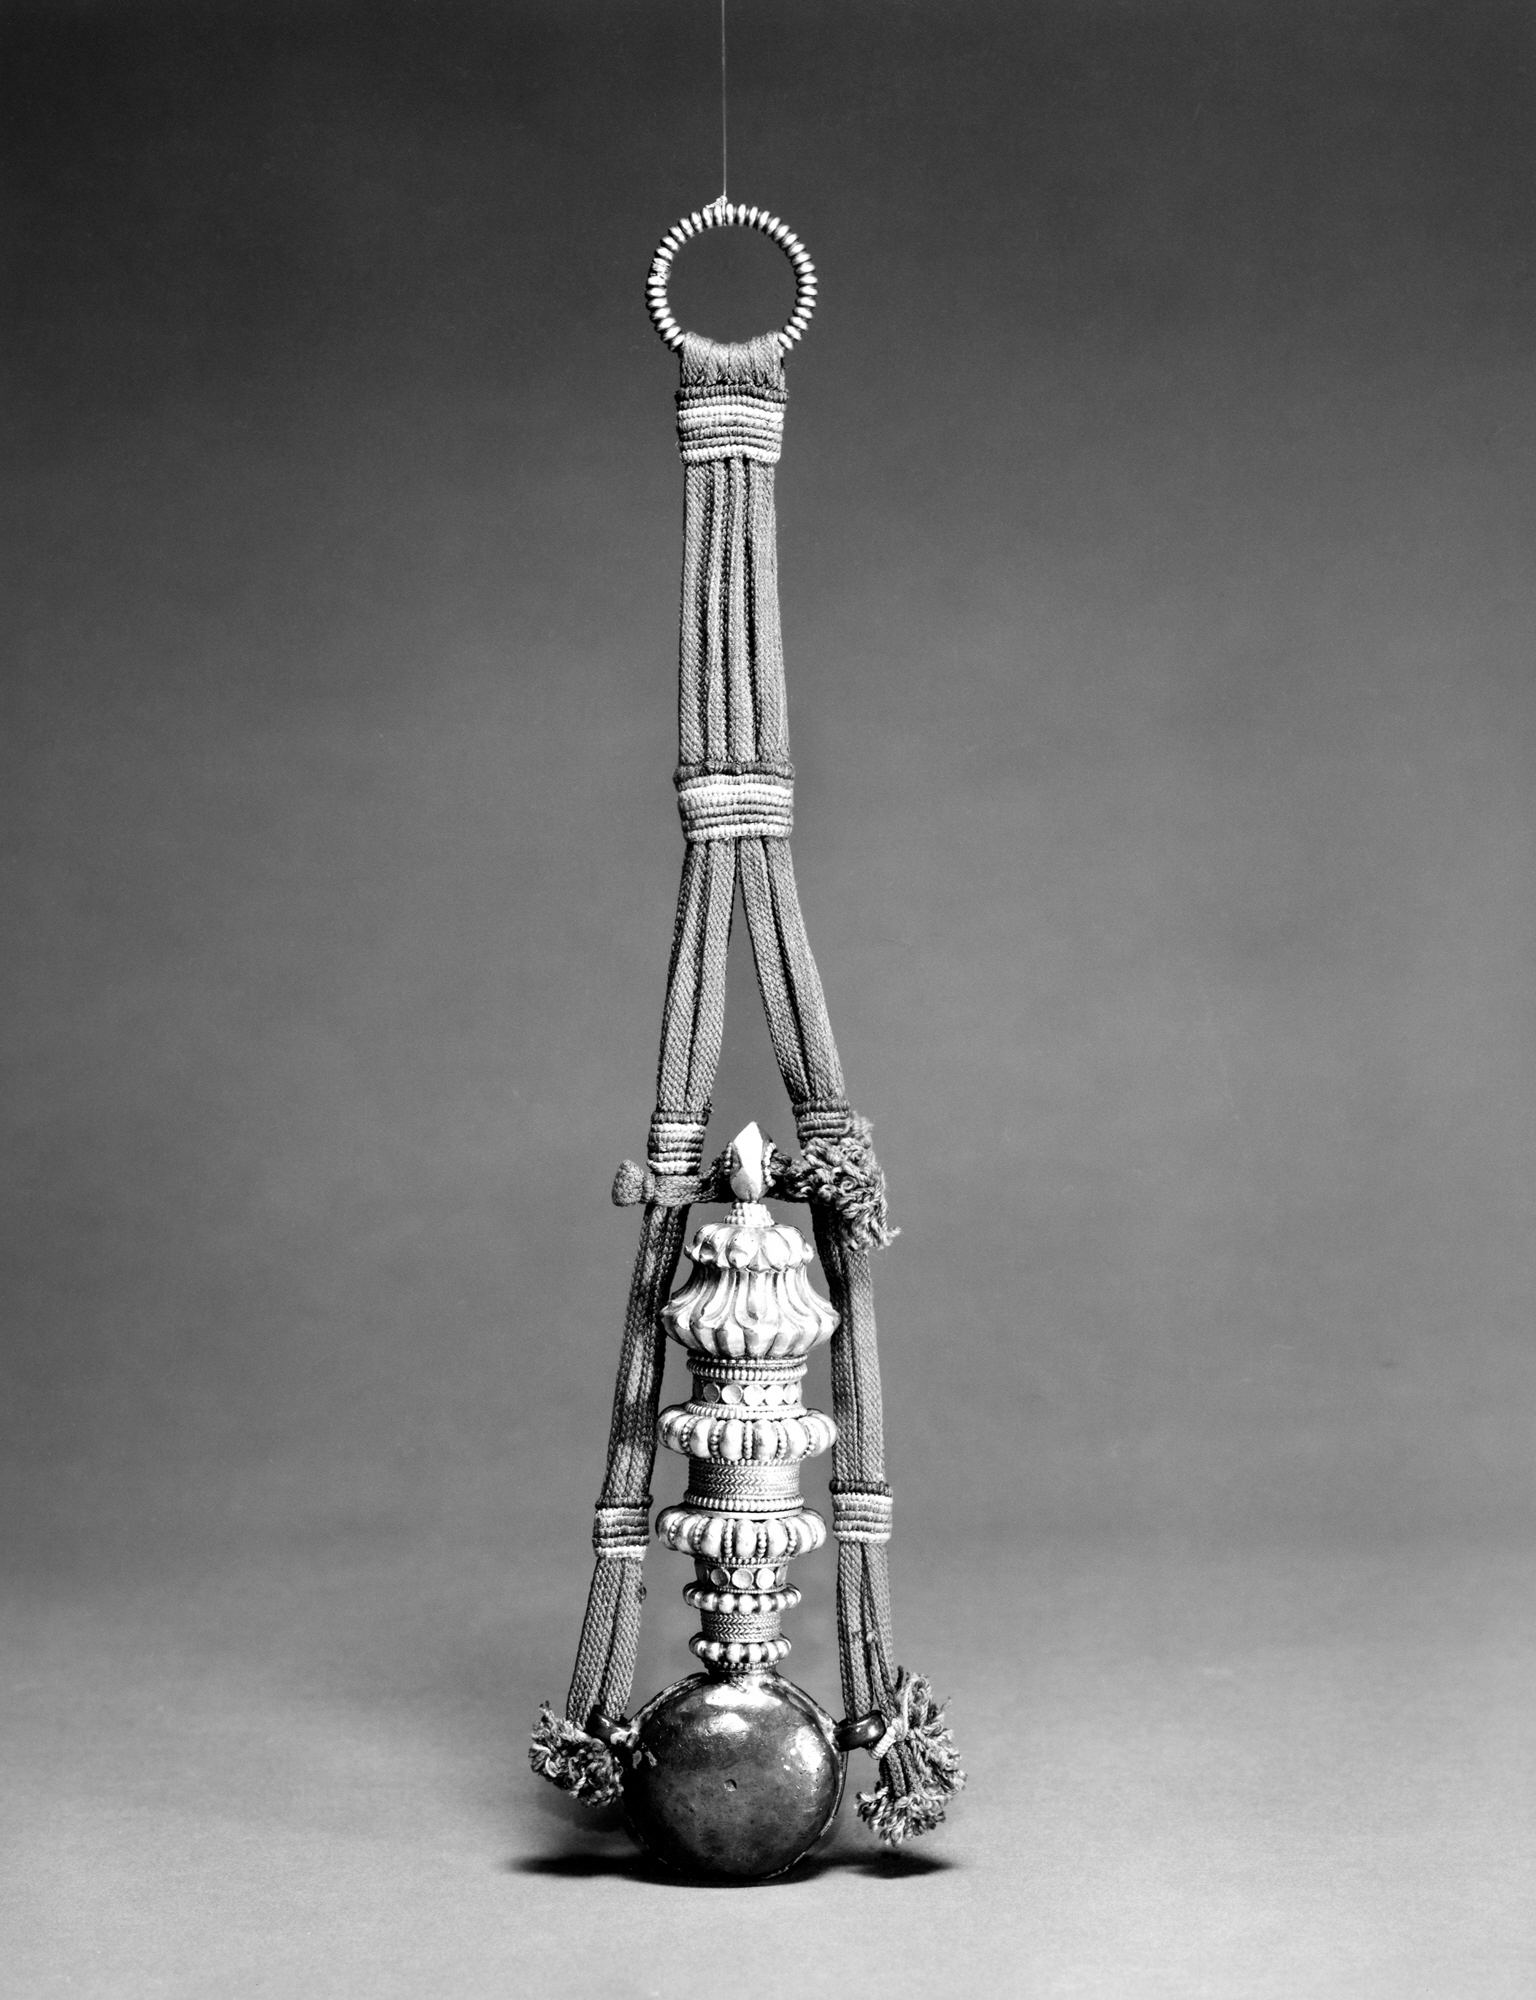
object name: holy water bottle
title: Holy water bottle and tapestry case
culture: tibetan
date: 1701-1800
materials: copper, metal thread, silk, silver gilt